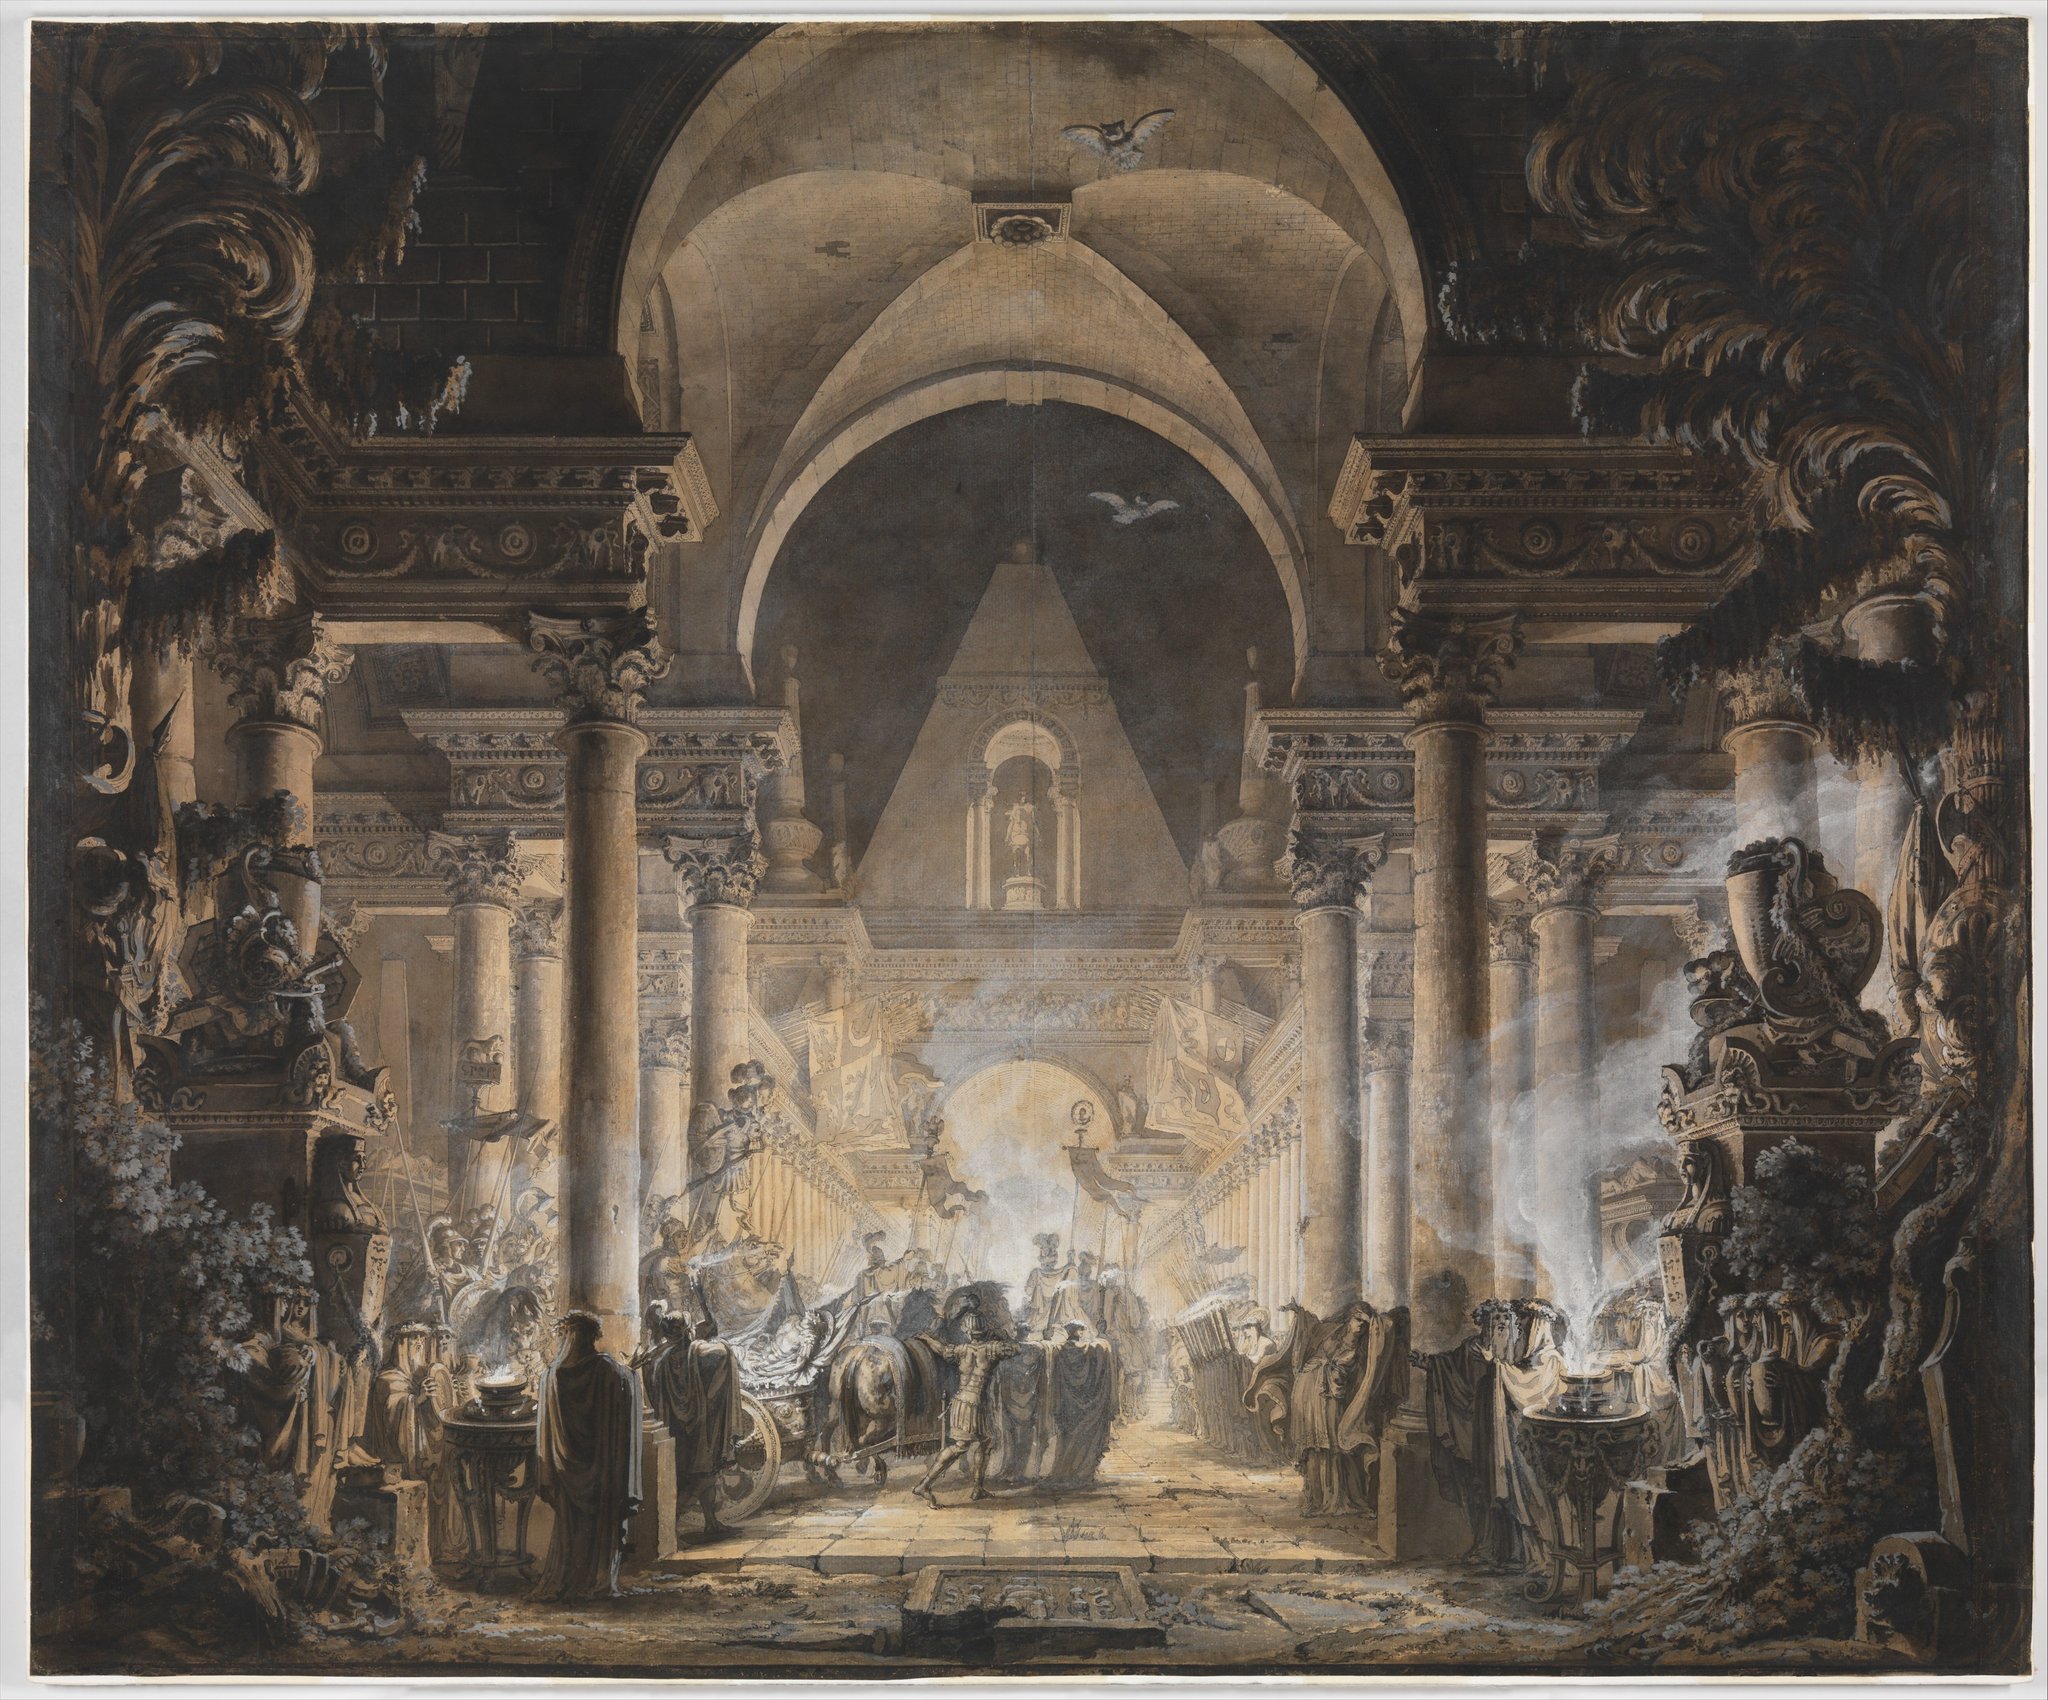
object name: drawing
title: The Tomb of Agamemnon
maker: louis jean desprez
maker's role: artist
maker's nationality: french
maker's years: 1743-1804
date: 1787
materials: gouache, ink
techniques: brush, heightening, pen, wash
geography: france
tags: opera,tombs